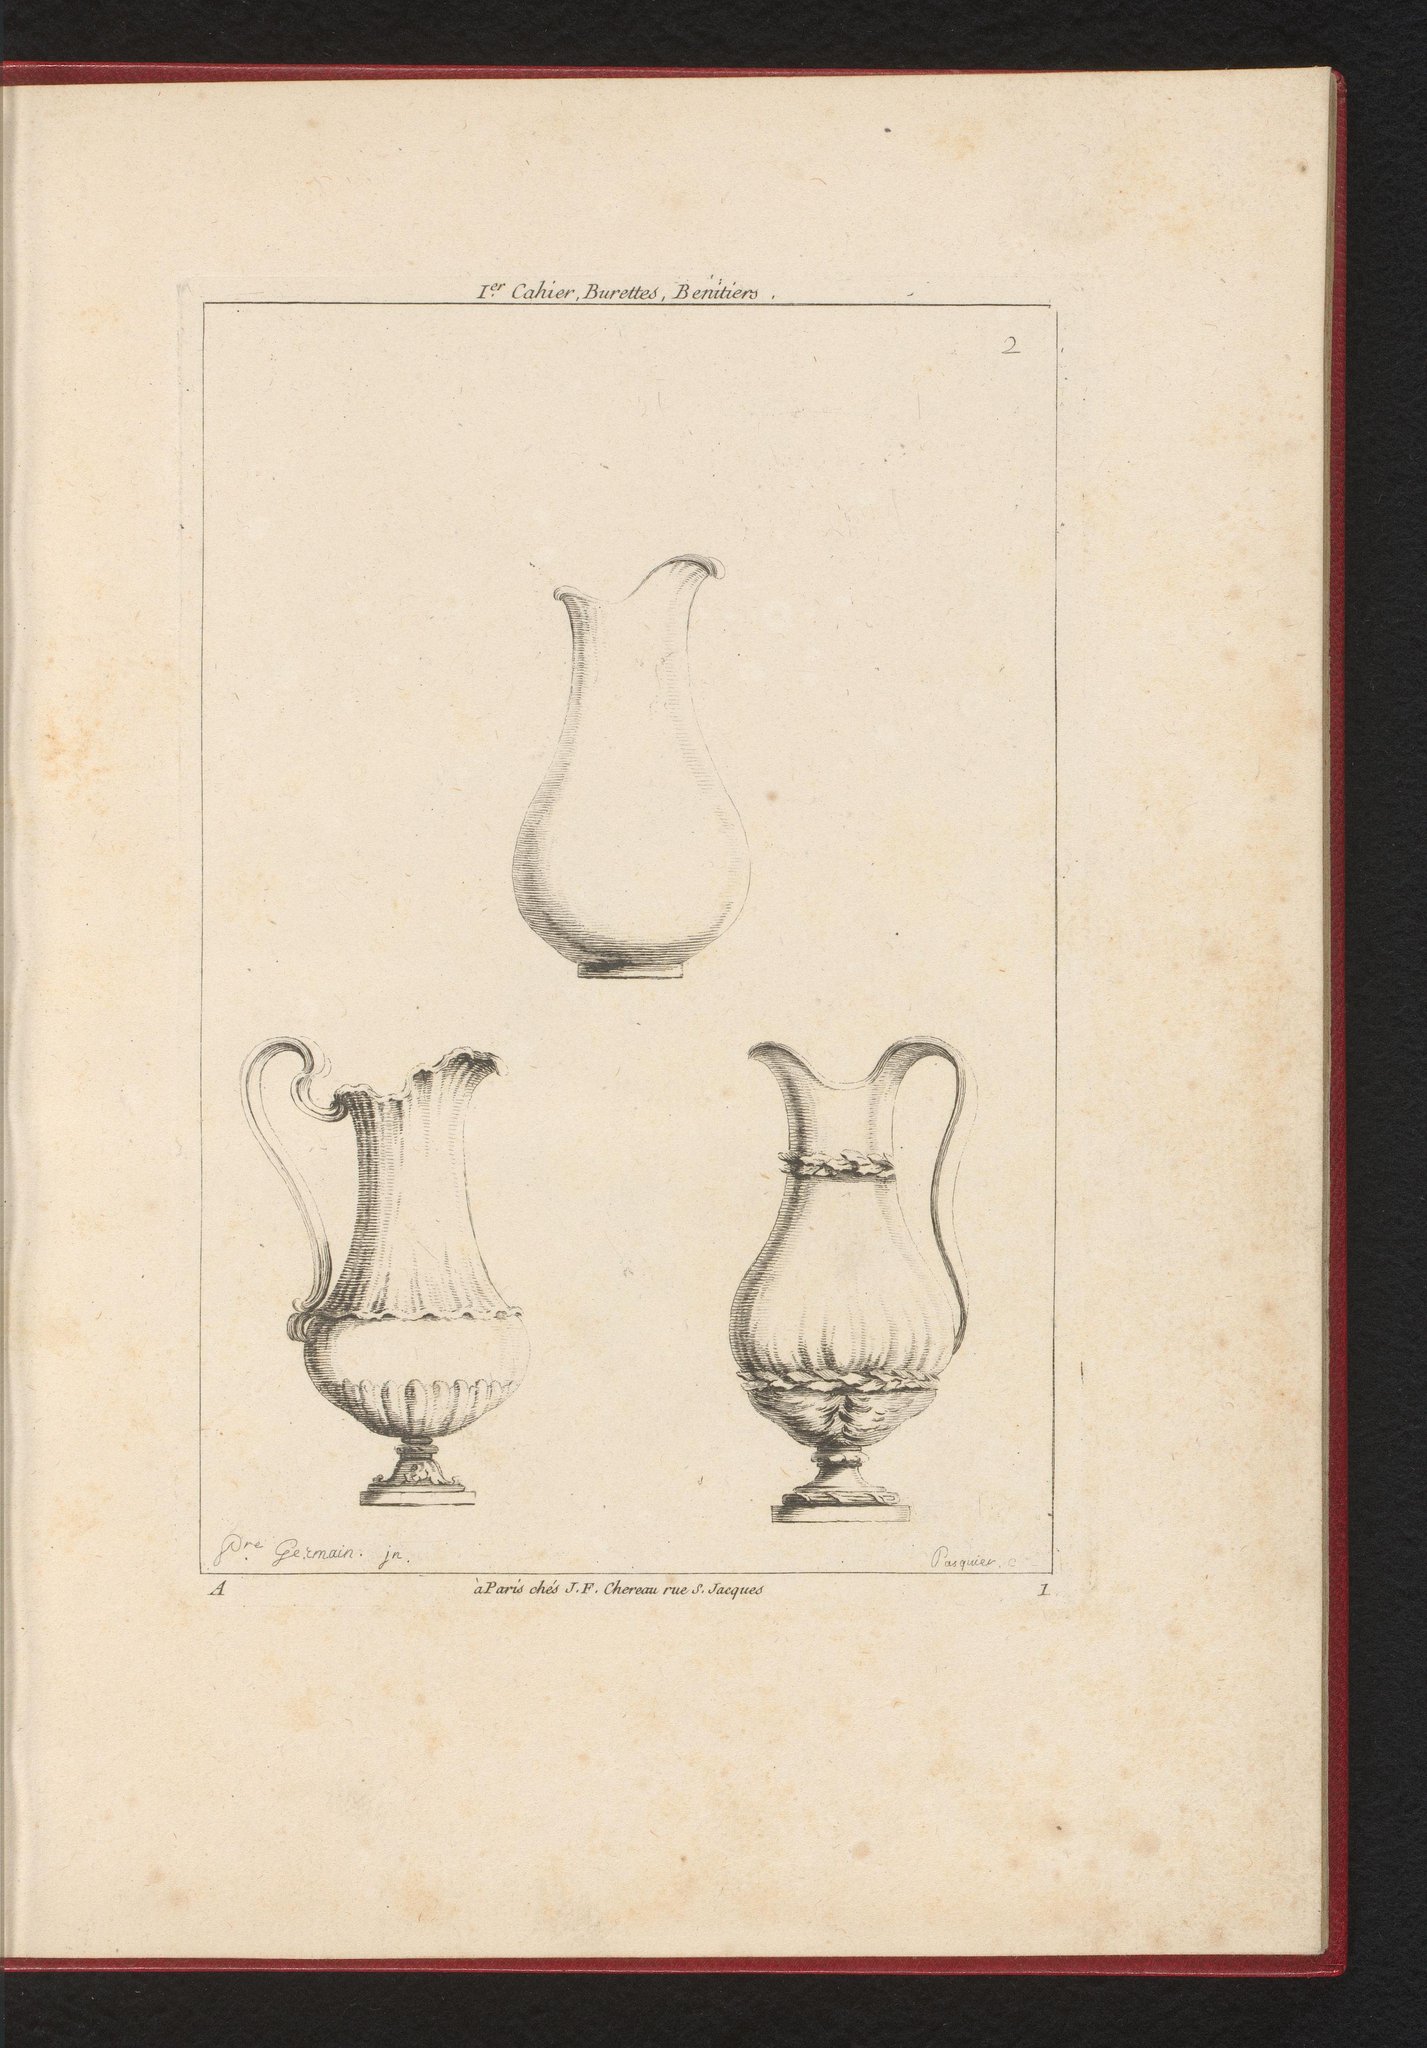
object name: album leaf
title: 1er. cahier burettes, benitiers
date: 1748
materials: paper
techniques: etching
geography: paris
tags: ornaments ~ art, cruets and basin ~ communion ware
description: Een aantal van de objecten in deze reeks heeft een eigen ondertitel, die verwijst naar genummerde 'cahiers' (afleveringen) waarin de prenten werden uitgegeven. Het is onduidelijk welke objecten recies bij welke aflevering horen. Daarom is die ondertitel enkel verwerkt bij de prent waarop die voorkomt.